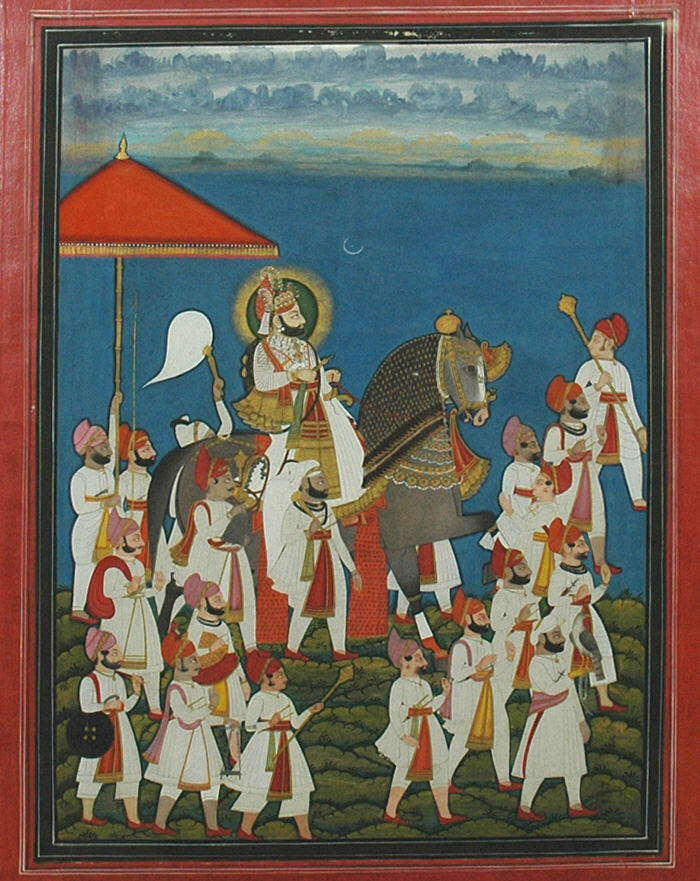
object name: painting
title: Equestrian Portrait of Maharana Bhim Singh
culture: mewar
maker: ghasi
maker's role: artist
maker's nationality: indian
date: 1825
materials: gold, paper, watercolor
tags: kings,men,portraits,horses